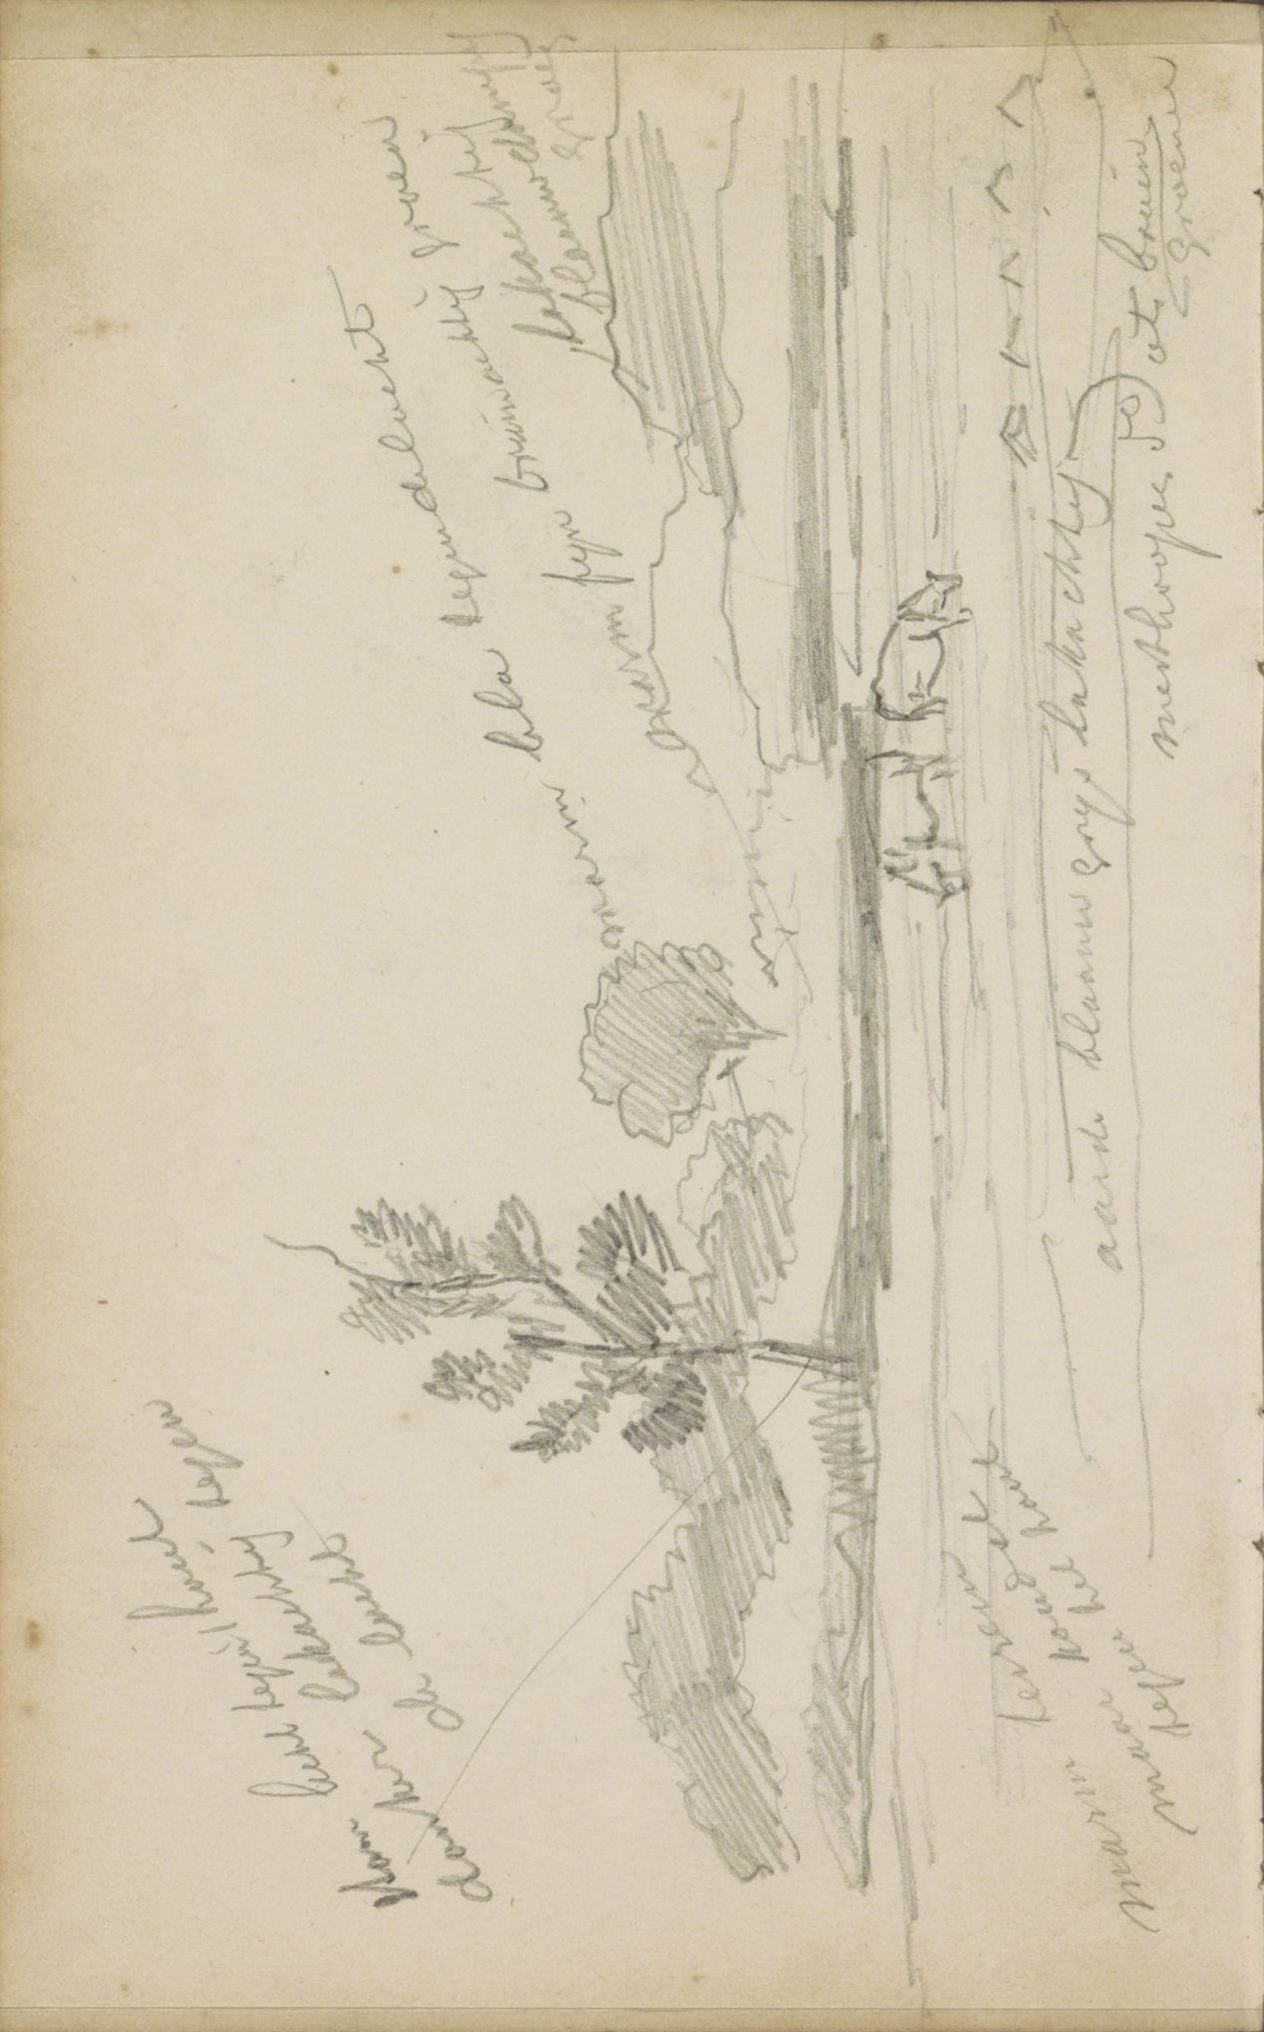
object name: sketchbook leaf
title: Heuvellandschap met grazende dieren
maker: johannes tavenraat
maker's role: draughtsman, painter, print maker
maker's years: 1809-1881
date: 1839-1872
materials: paper, pencil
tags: low hill country, cattle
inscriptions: kleurnotitie, handgeschreven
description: Blad 20 verso uit een schetsboek met 73 bladen.